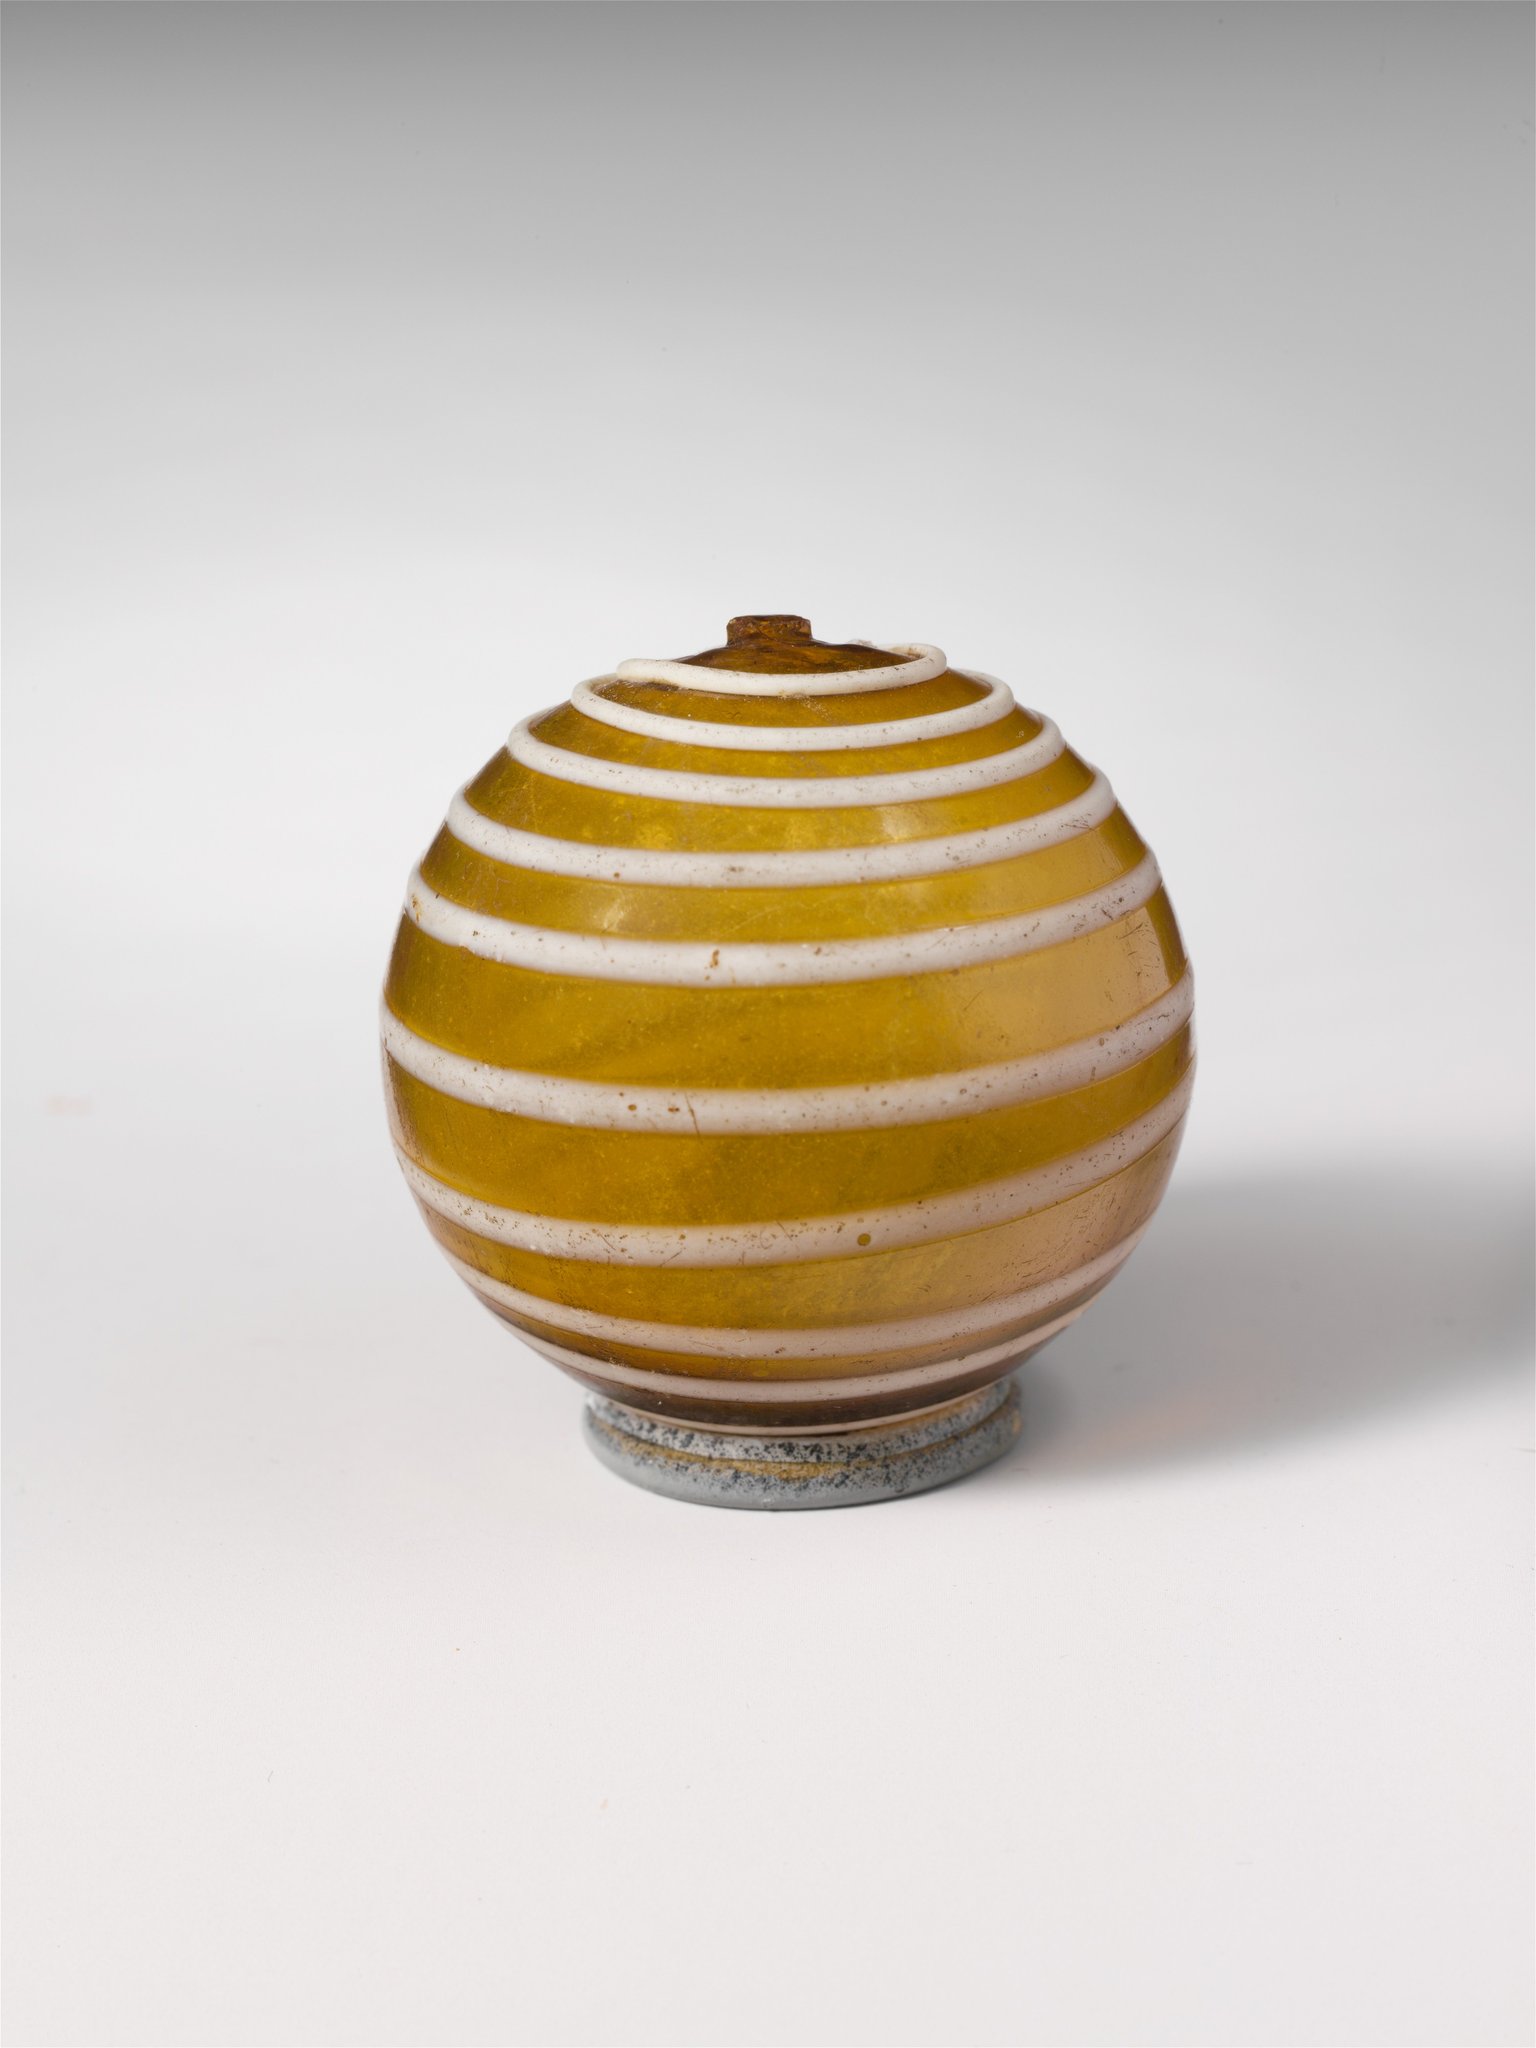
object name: sphere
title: Glass spherical bottle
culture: roman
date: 1-33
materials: glass